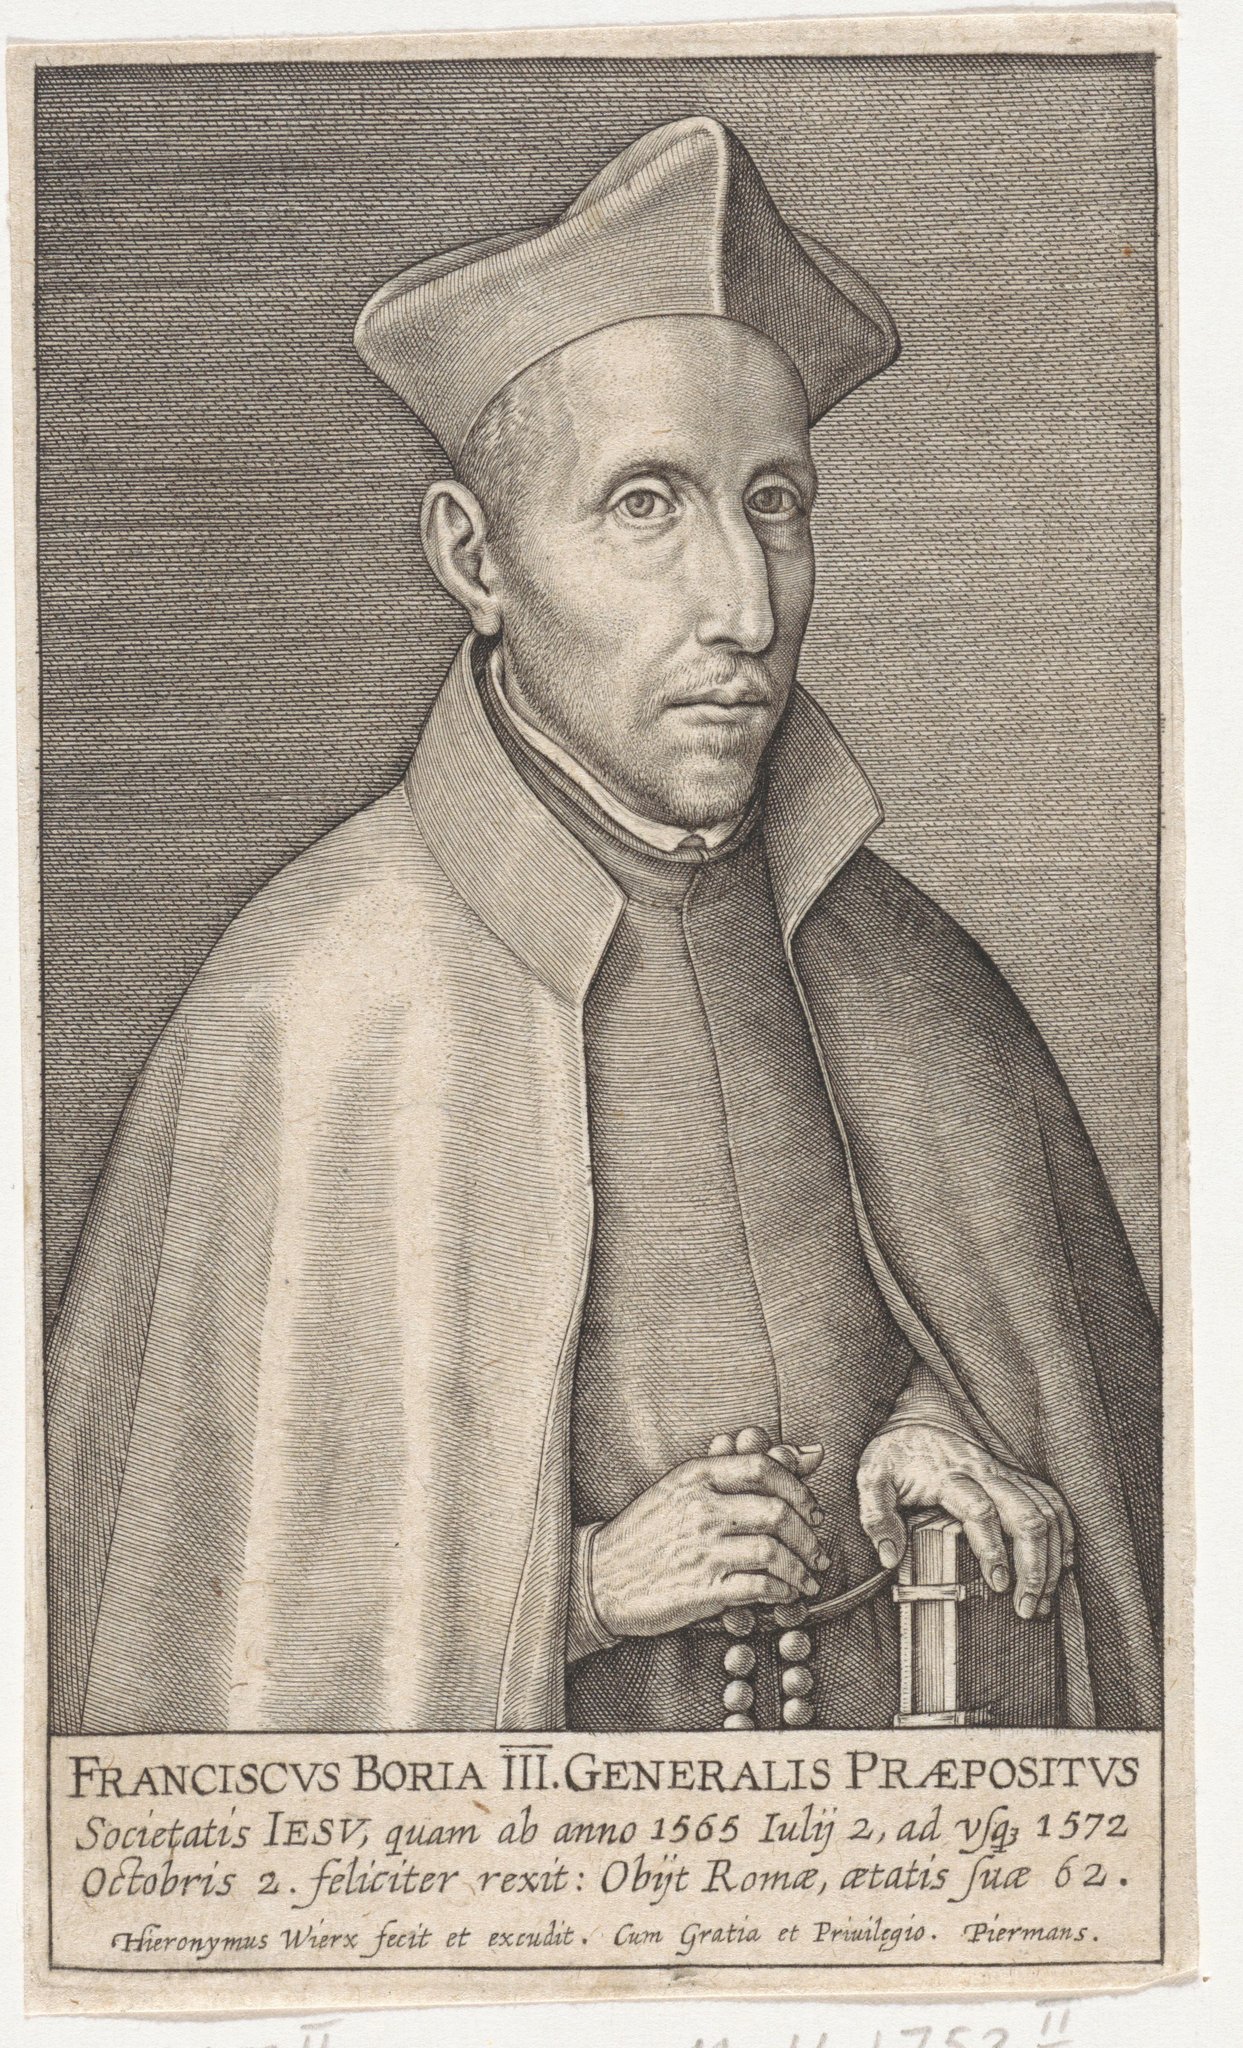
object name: print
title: Effigies præpositorvm generalivm societatis Iesv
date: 1615-1619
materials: paper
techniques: engraving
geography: antwerp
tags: clergyman, aids for prayer, e.g. rosary, the bible as a book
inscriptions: collector's mark: Lugt 2228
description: Portret van de jezuïet Franciscus Borgia, in zijn handen een bijbel en een rozenkrans. In de marge een drieregelig onderschrift in het Latijn.